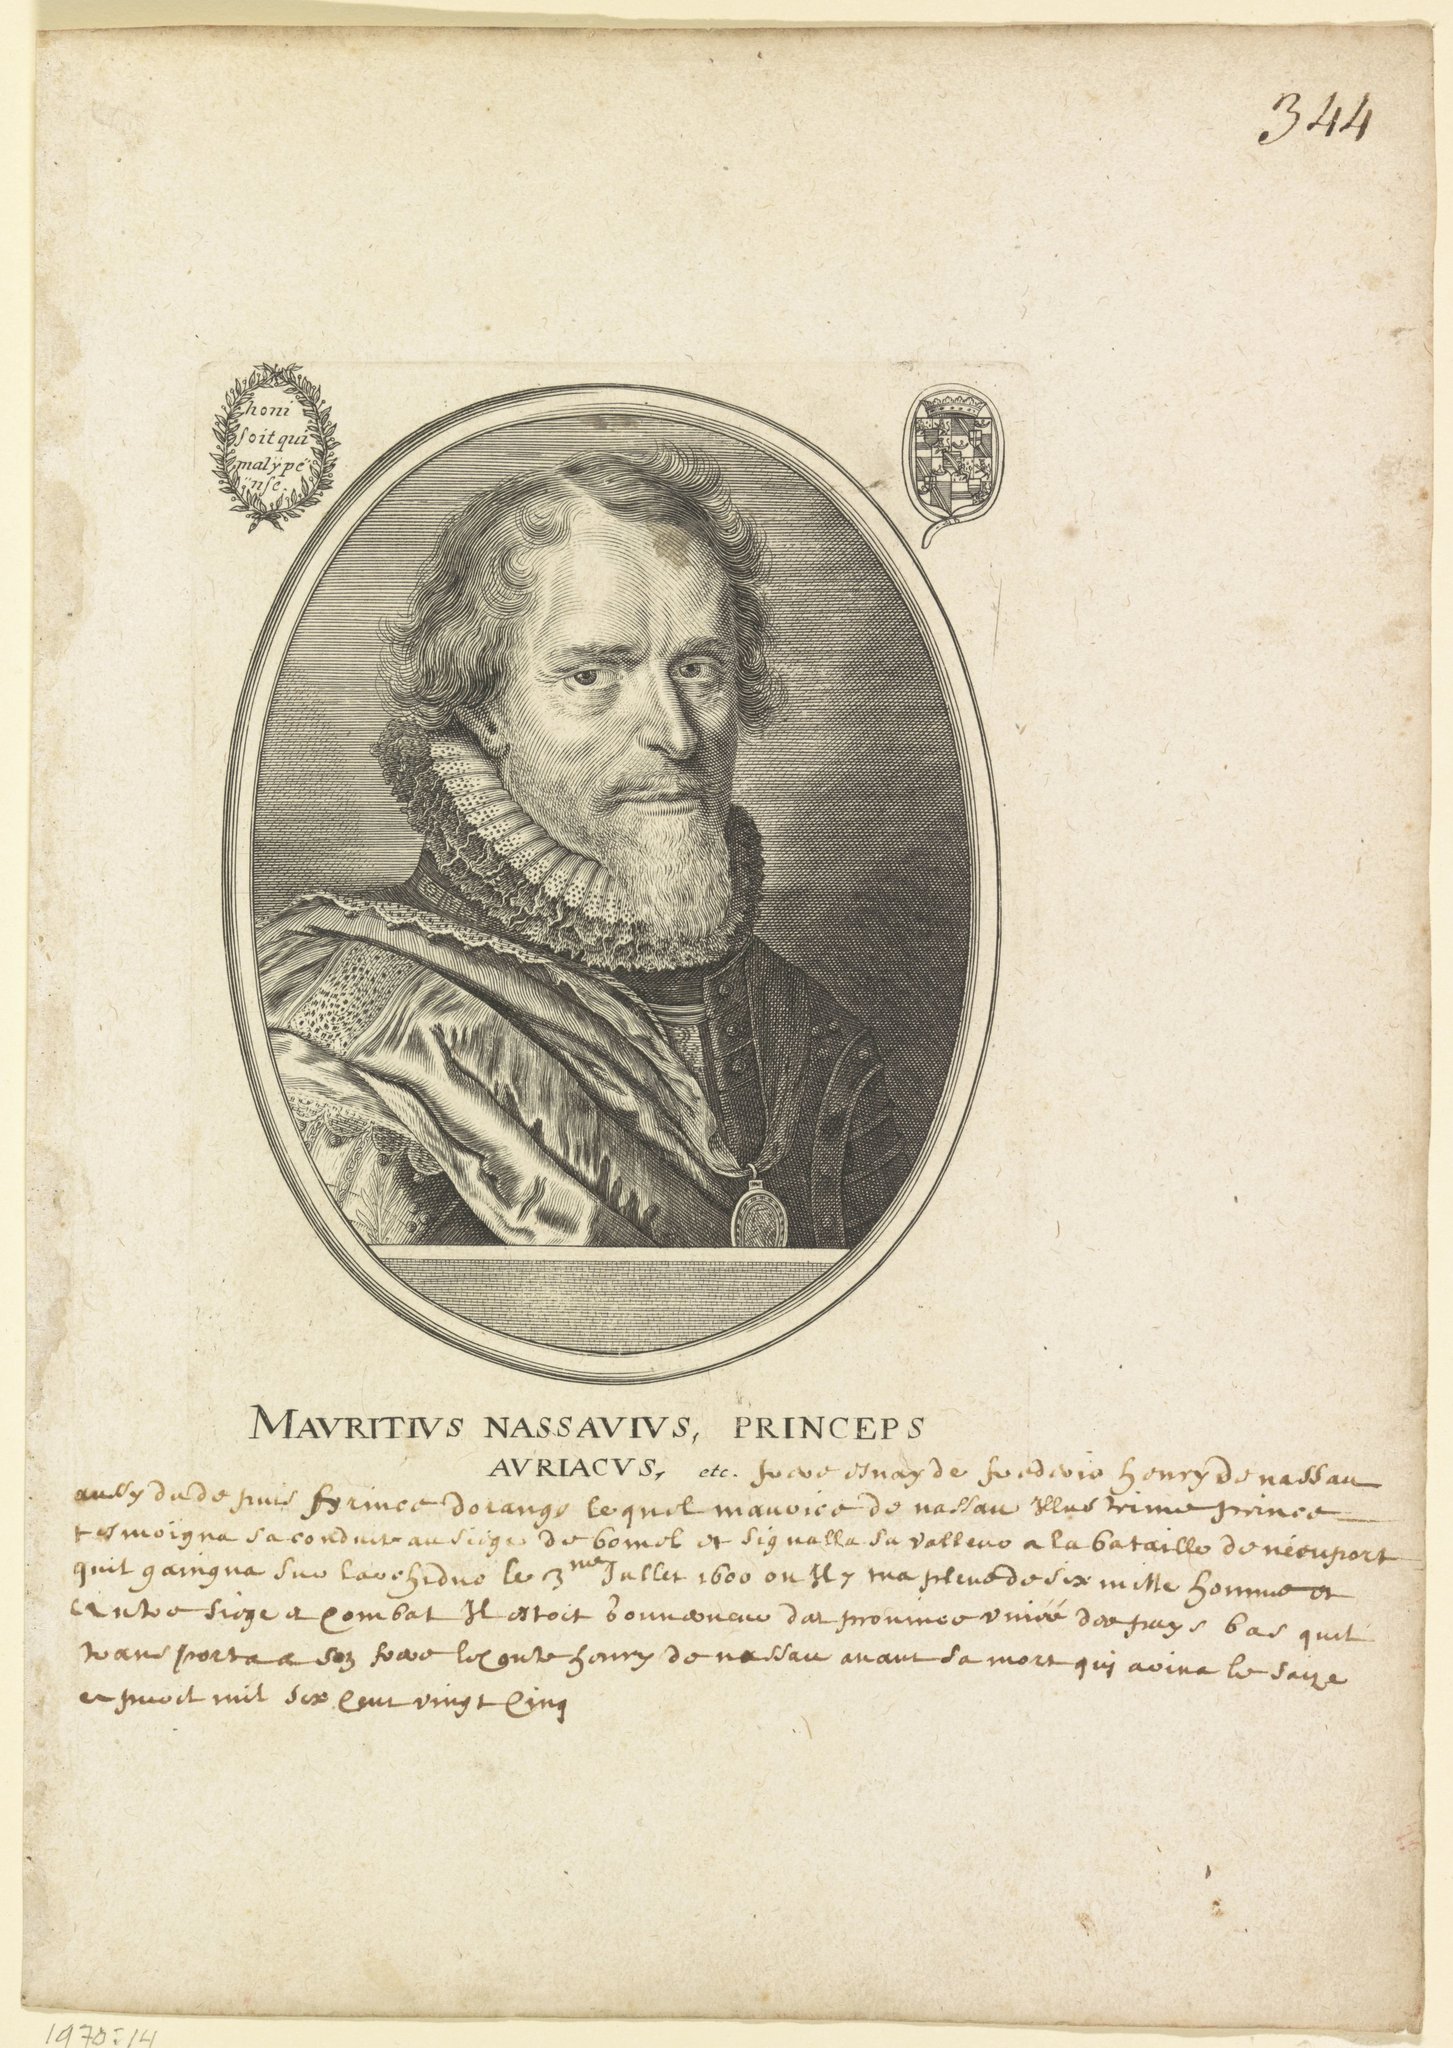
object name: print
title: Portret van Maurits, prins van Oranje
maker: Anonymous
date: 1600-1699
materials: paper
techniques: engraving, etching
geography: low countries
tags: the hague, maurice (prince of orange), knighthood order (garter) - insignia of a knighthood order, e.g.: badge, chain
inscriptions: inscription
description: Portret van Maurits in een ovaal. Linksboven het devies van de Orde van de Kousenband en rechtsboven zijn wapen, gedecoreerd met de Kousenband. In de ondermarge zijn naam.